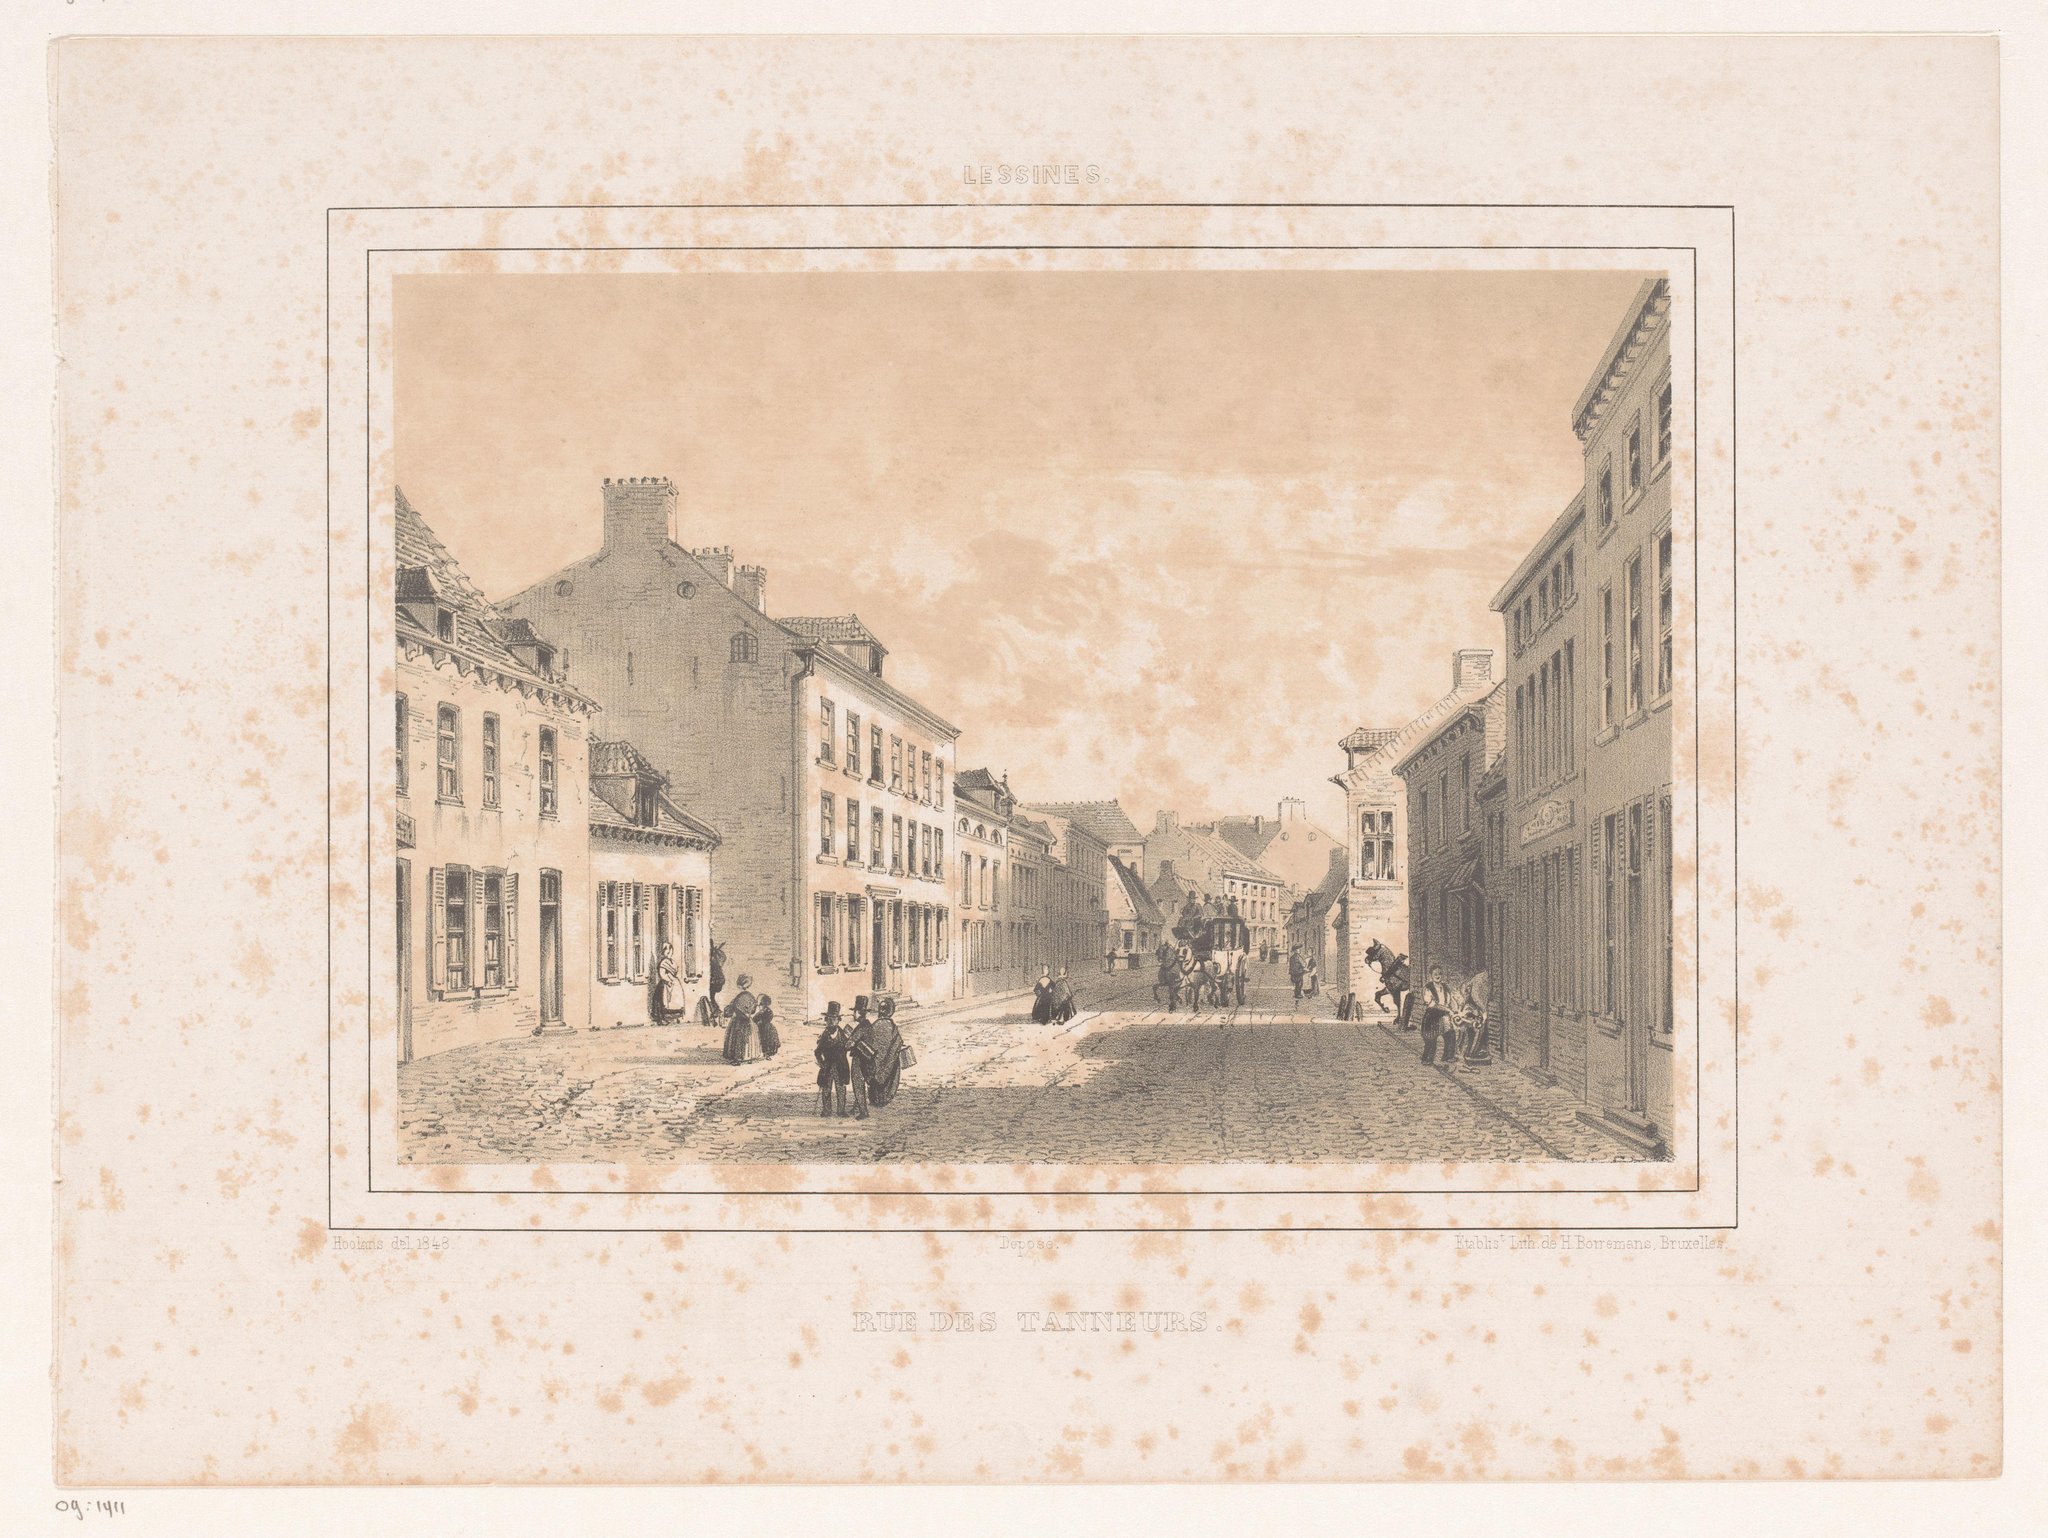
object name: print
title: Rue des Tanneurs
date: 1848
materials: paper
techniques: tone lithography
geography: brussels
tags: four-wheeled vehicle drawn by two animals, street, city-view in general; 'veduta' (+ city(-scape) with figures, staffage)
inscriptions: : ‘Déposé’, collector's mark: Lugt 2228